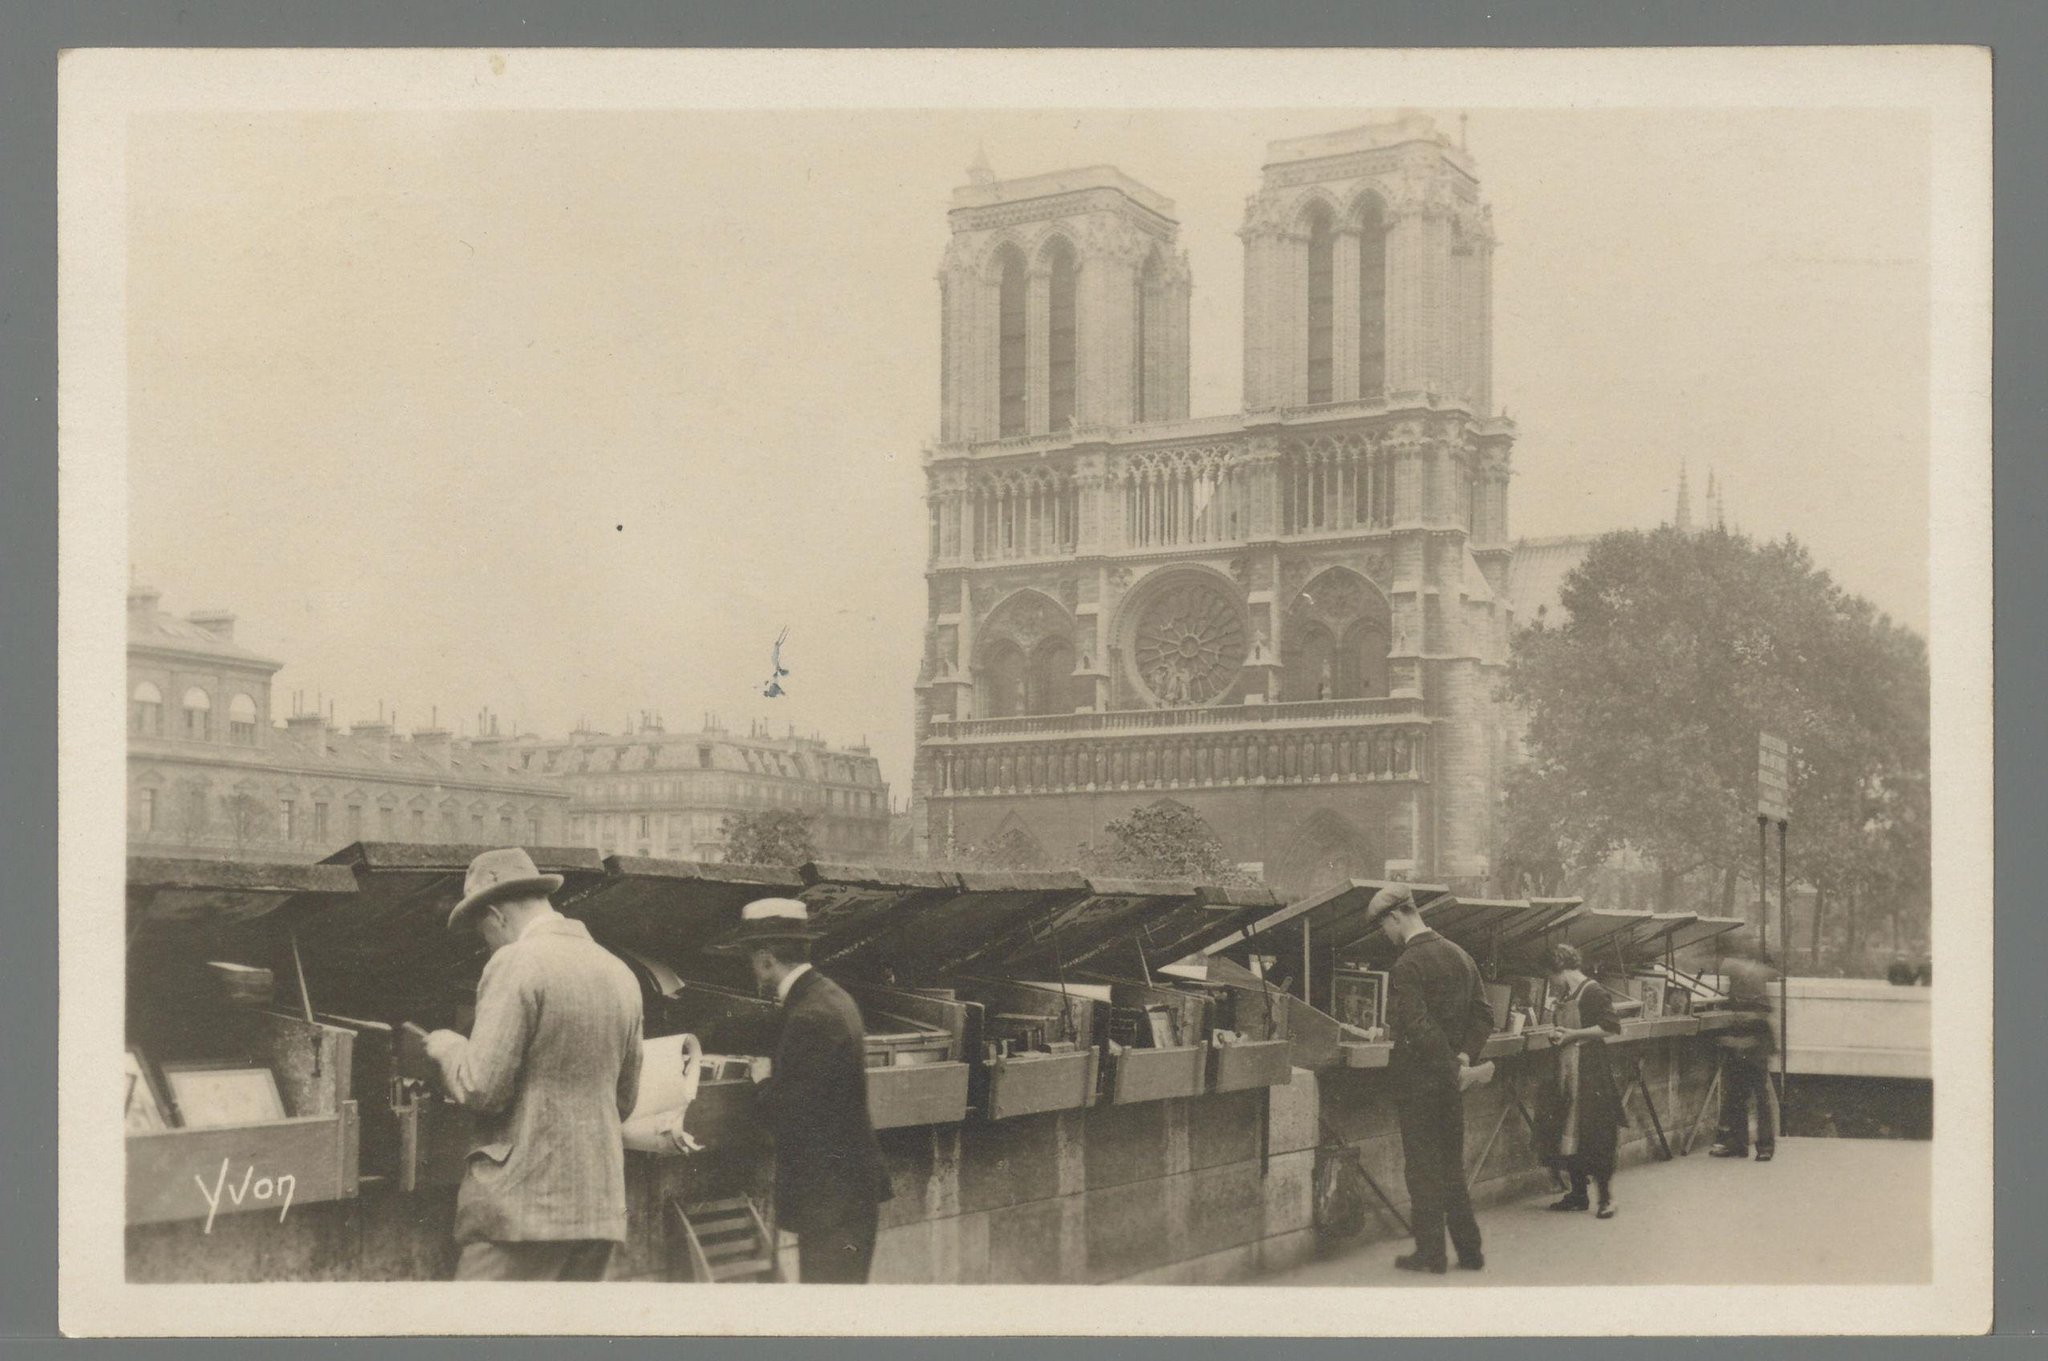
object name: ansichtkaart, prentbriefkaart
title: Paris... en flanant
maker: Anonymous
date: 1903-1930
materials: photographic support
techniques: photography, writing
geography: paris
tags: book-stall, kiosk, church (exterior)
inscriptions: postage stamp